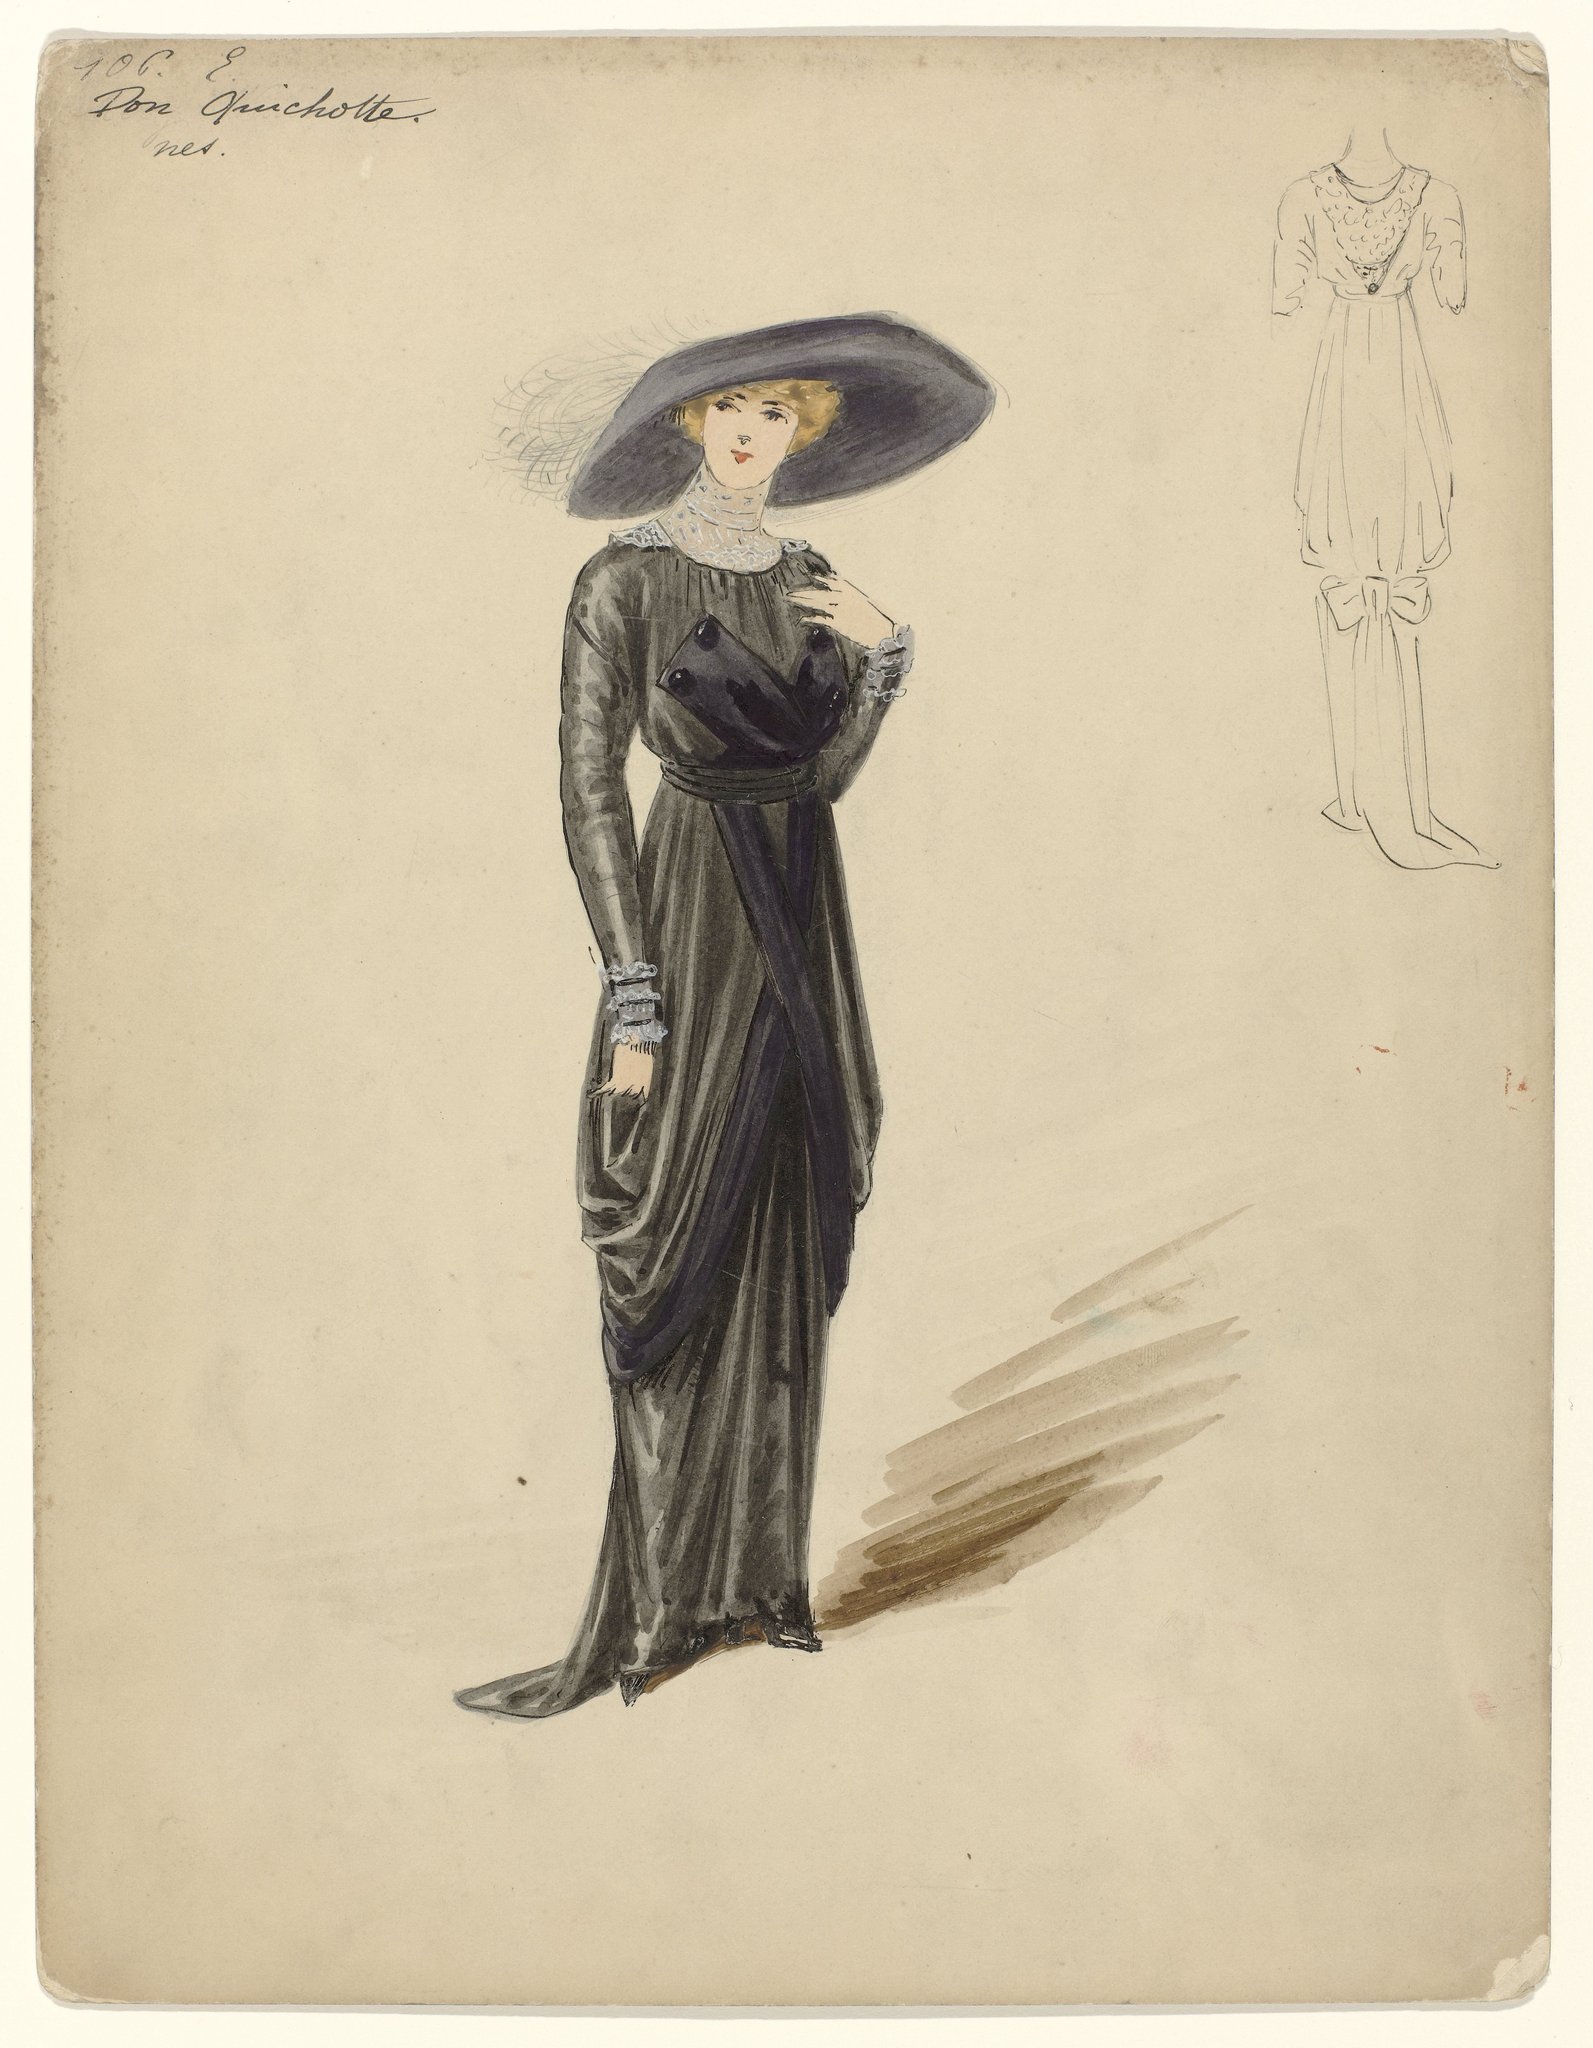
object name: drawing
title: Japon 'Don Quichotte' van Doeuillet, 1910, No. 106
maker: Anonymous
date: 1910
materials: ink, paper, watercolor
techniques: brush, pen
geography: france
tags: fashion plates, head-gear: hat (+ women's clothes), dress, gown (+ women's clothes)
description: Japon uit 1910 van het modehuis Doeuillet met de naam 'Don Quichotte'.